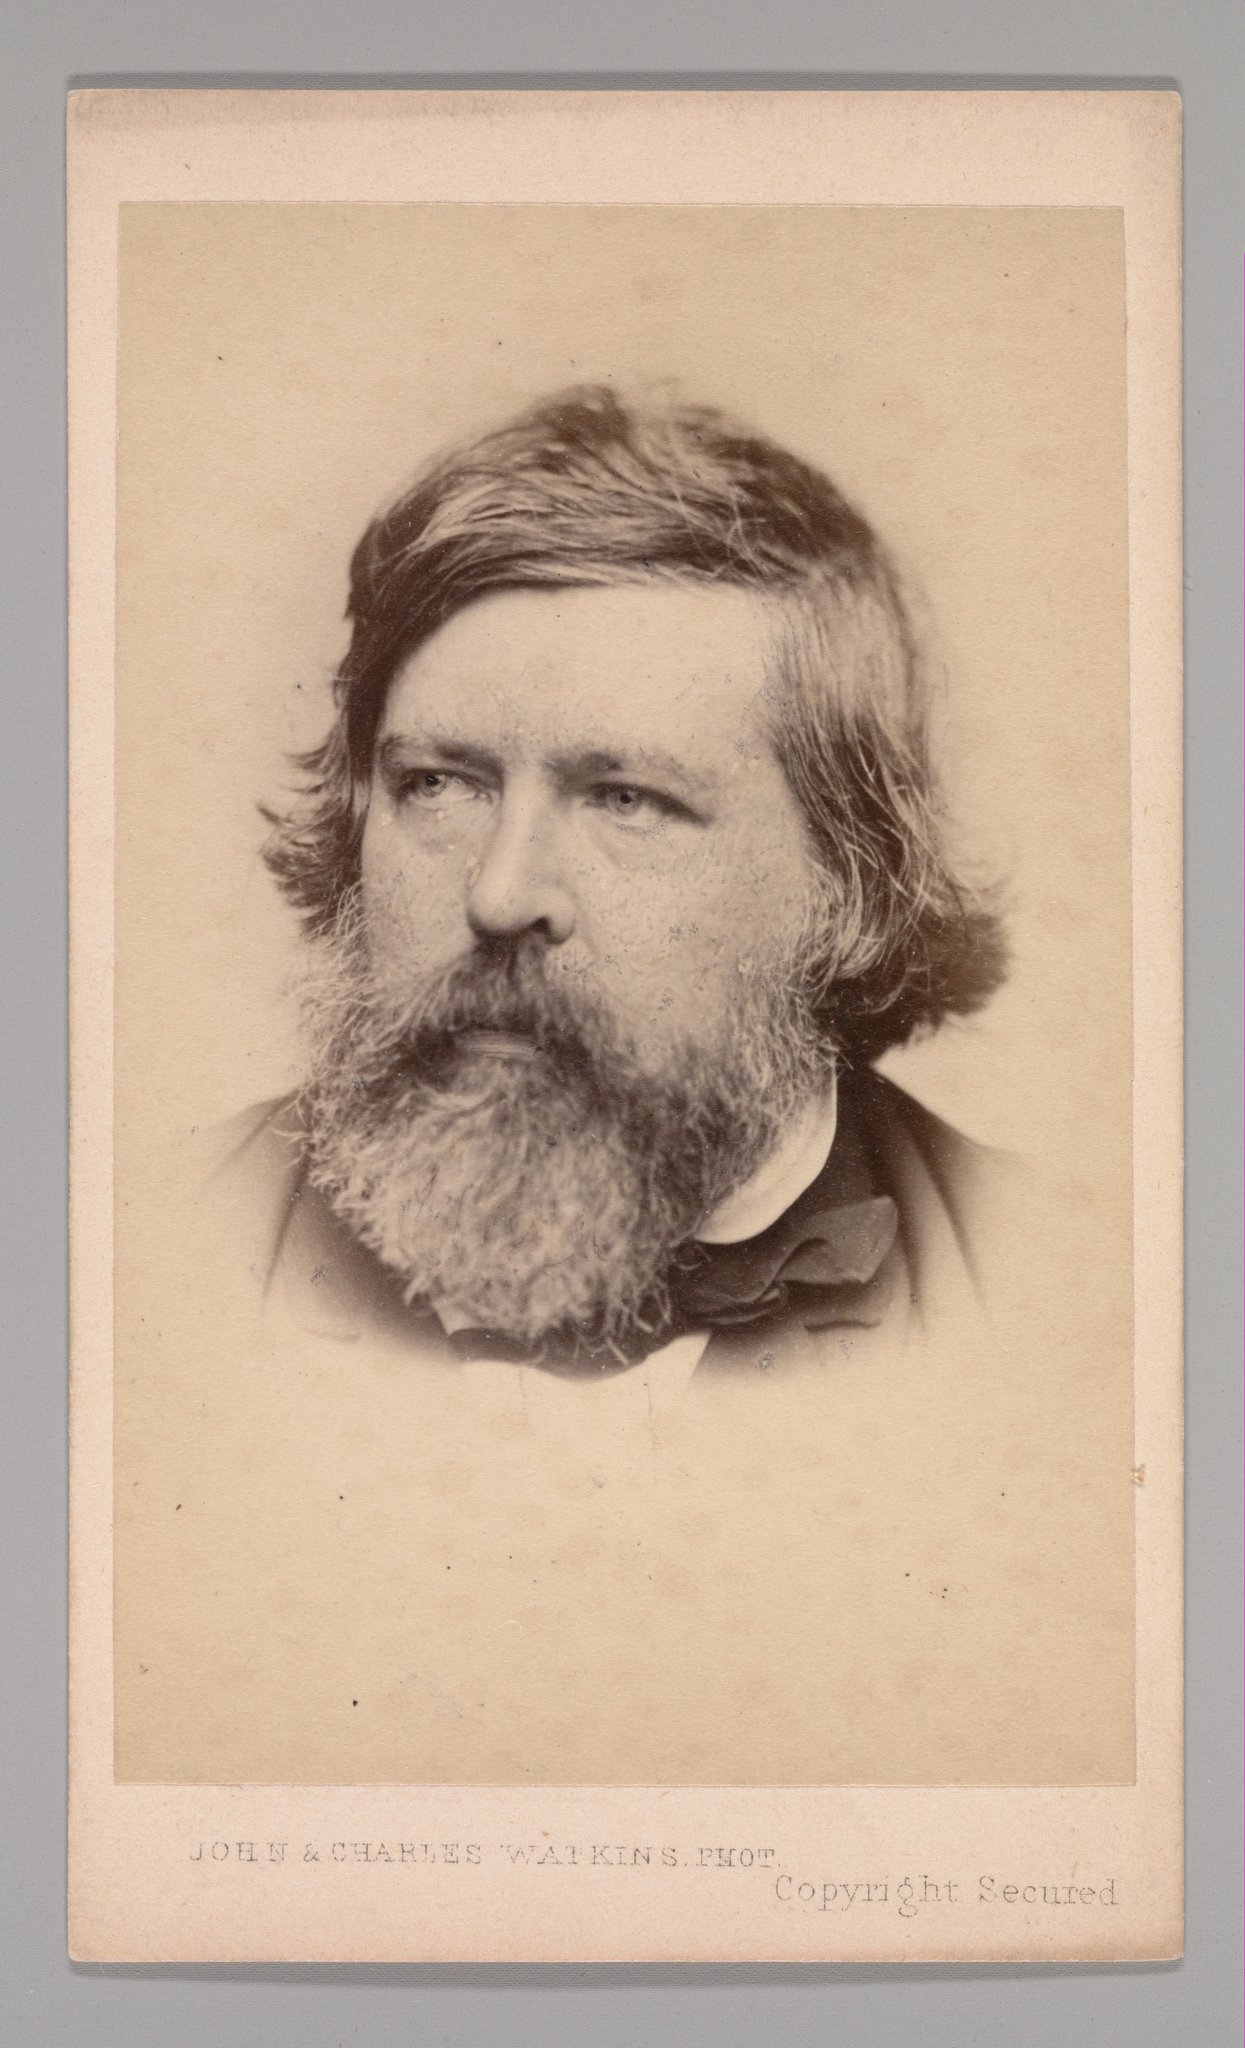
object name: carte de visite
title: [Unknown Subject]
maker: john and charles watkins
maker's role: photography studio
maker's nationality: british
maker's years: 1840-1875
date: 1860-1869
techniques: albumen silver print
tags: men,portraits